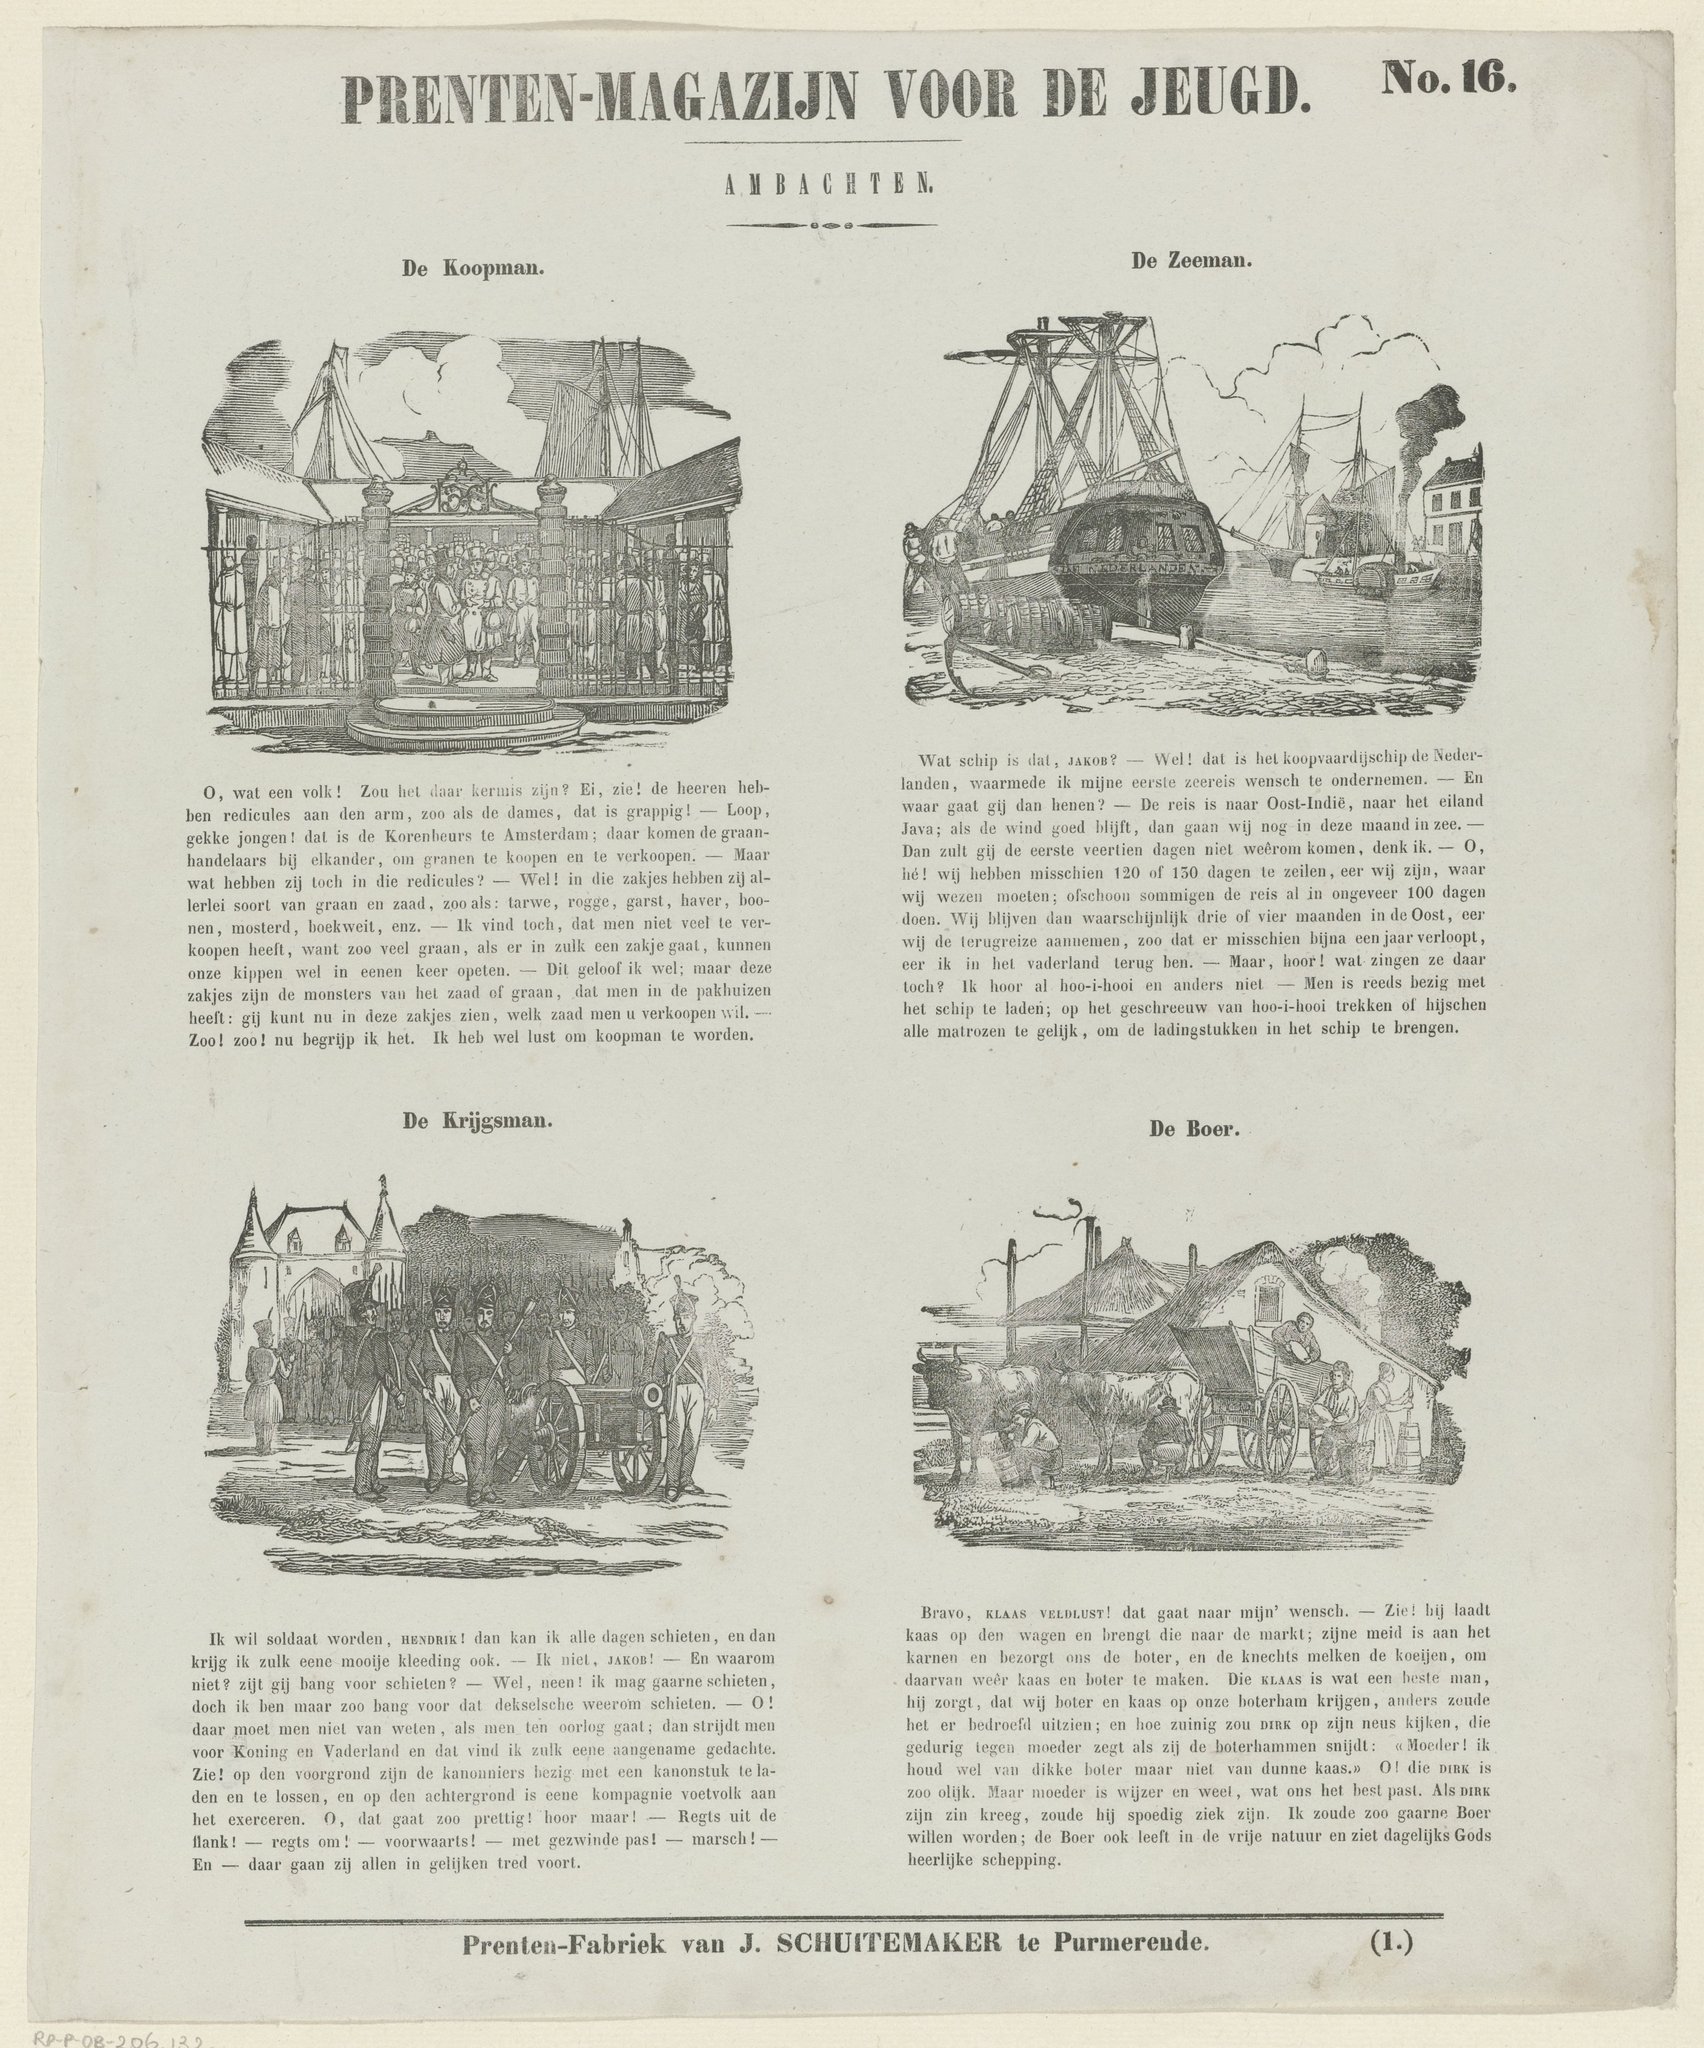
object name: print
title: Ambachten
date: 1850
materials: paper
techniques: letterpress printing, engraving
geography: purmerend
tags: farmers, street-trader, the soldier; the soldier's life, seaman: sailor, merchant, salesman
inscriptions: collector's mark: Lugt 2760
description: Na voltooiing van de acht jaargangen van de reeks 'Prenten-magazijn voor de jeugd' in 1850 heeft Jan Schuitemaker al deze prenten heruitgegeven en omgenummerd als nr. 1 t/m 192. De oorspronkelijke jaargang wordt telkens nog vermeld rechtsonder op de prent. Binnen de jaargangen zijn prenten van hetzelfde thema in clusters van vier achter elkaar gezet.